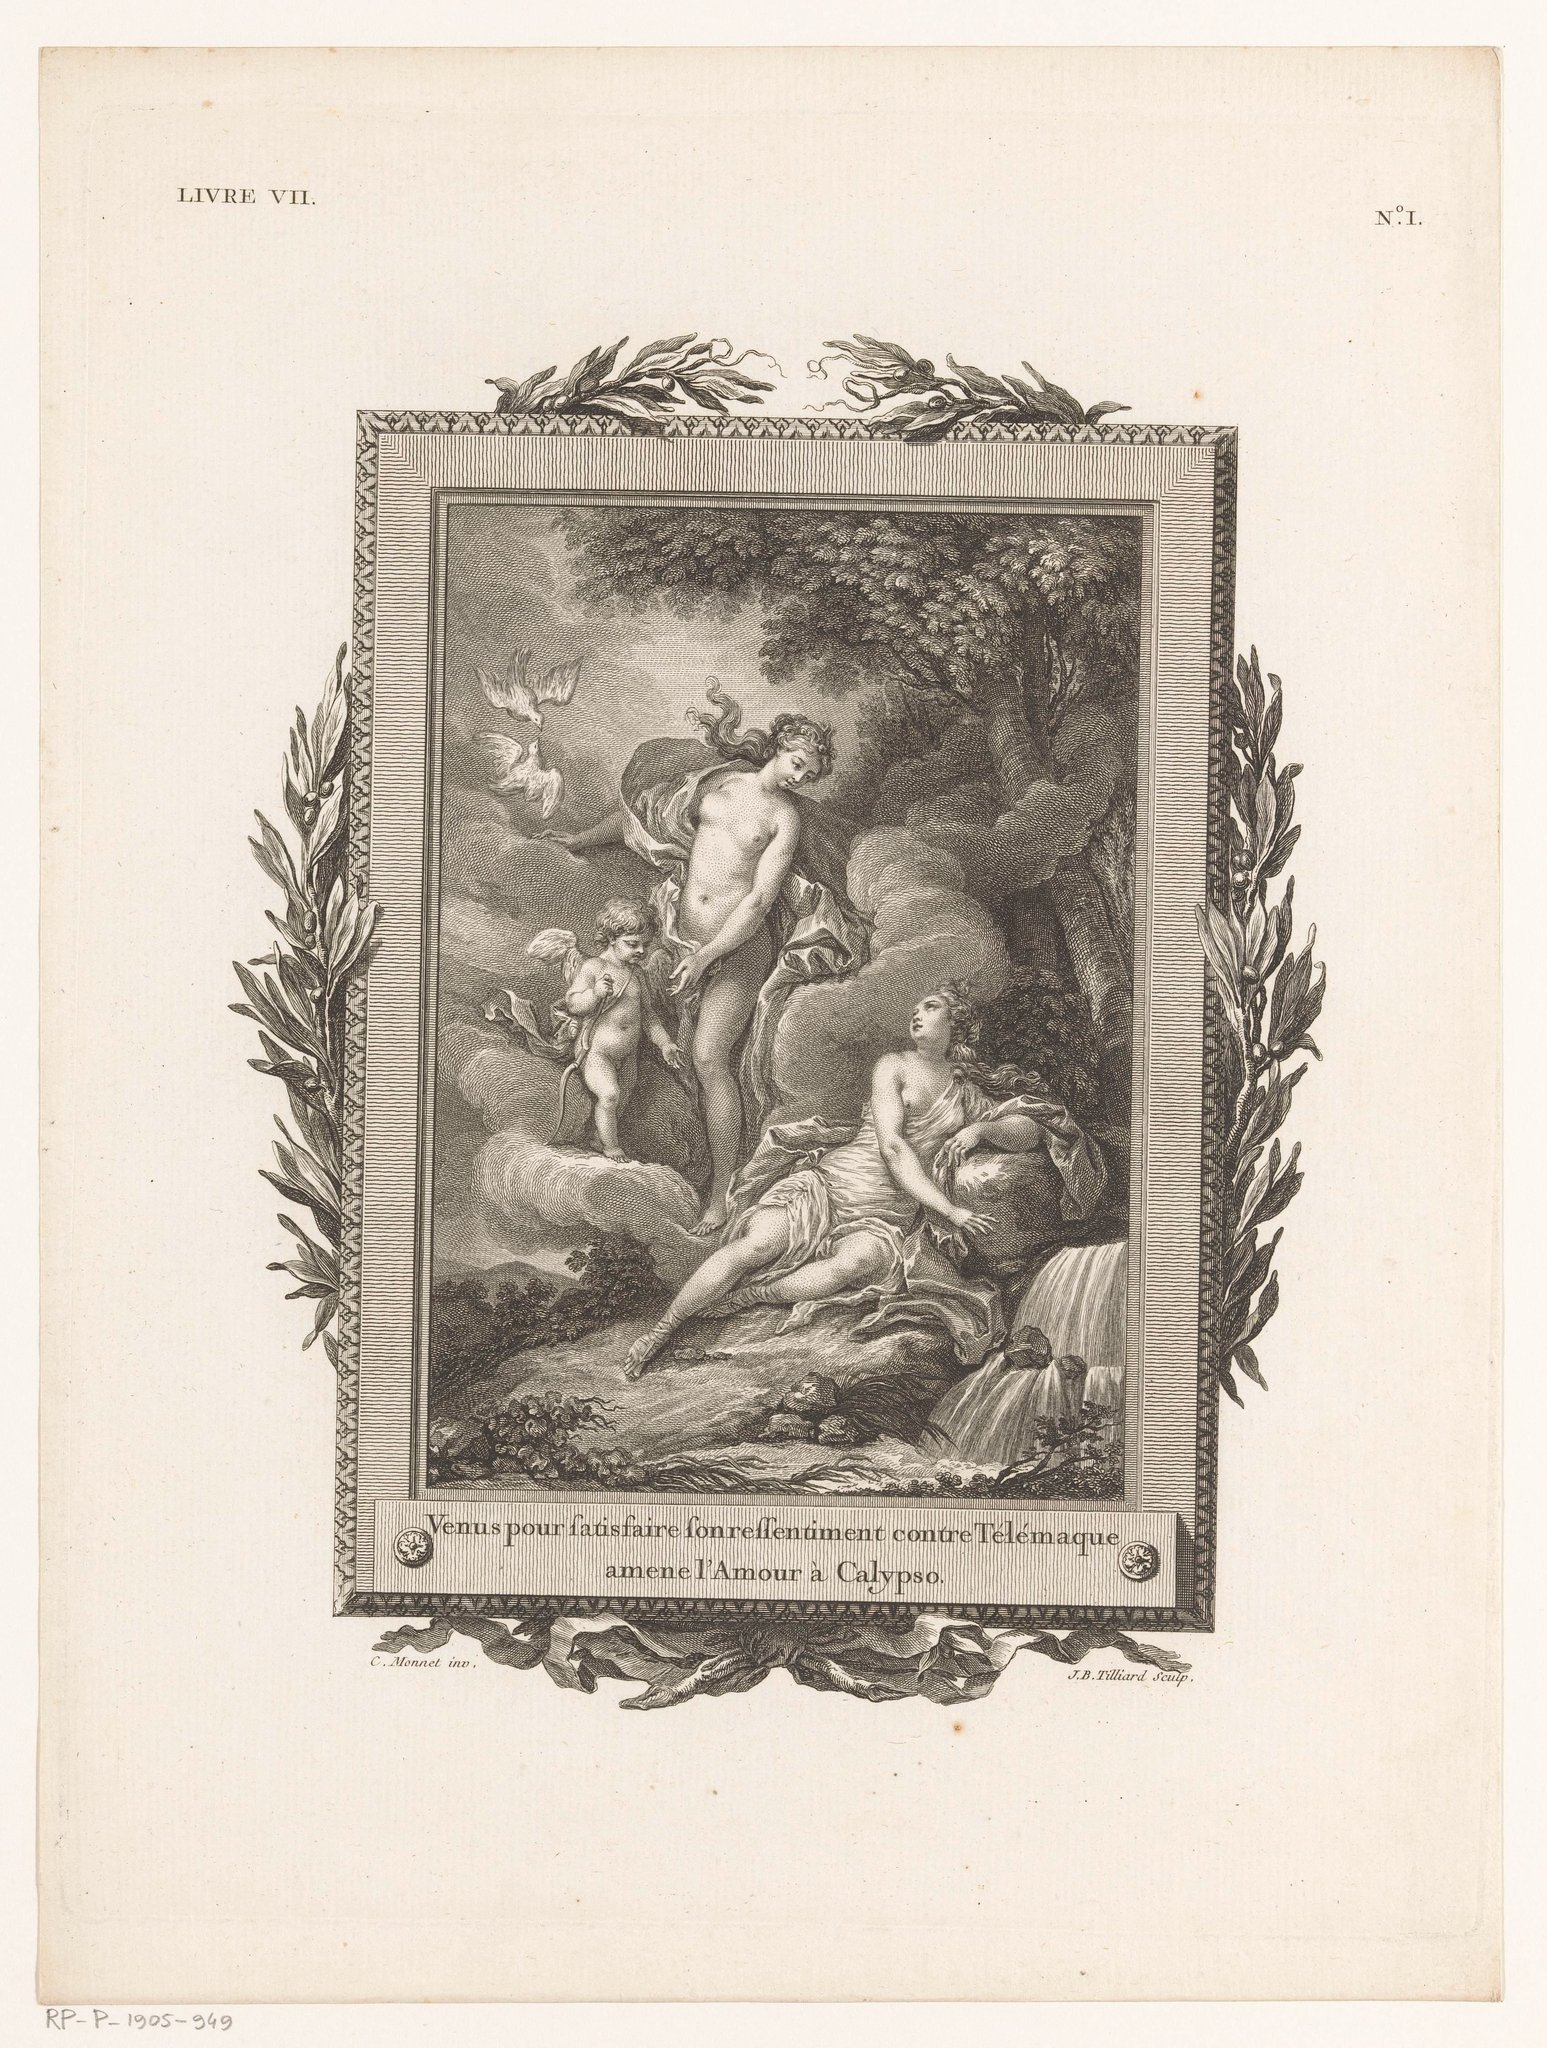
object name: book illustration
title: Venus en Cupido bij Calypso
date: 1785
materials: paper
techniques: engraving, etching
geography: paris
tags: (fenelon, telemachus) specific works of literature (with author, title), (story of) venus (aphrodite), telemachus and calypso, ornament ~ festoon, garland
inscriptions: collector's mark: Lugt 2228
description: Calypso, zittend op een rots naast een waterval wordt bezocht door Venus met Cupido van een wolk afstappend. Het geheel wordt gekaderd door een sierlijst met olijftakken en onderaan een strik. Genummerd rechtsboven: No. I.